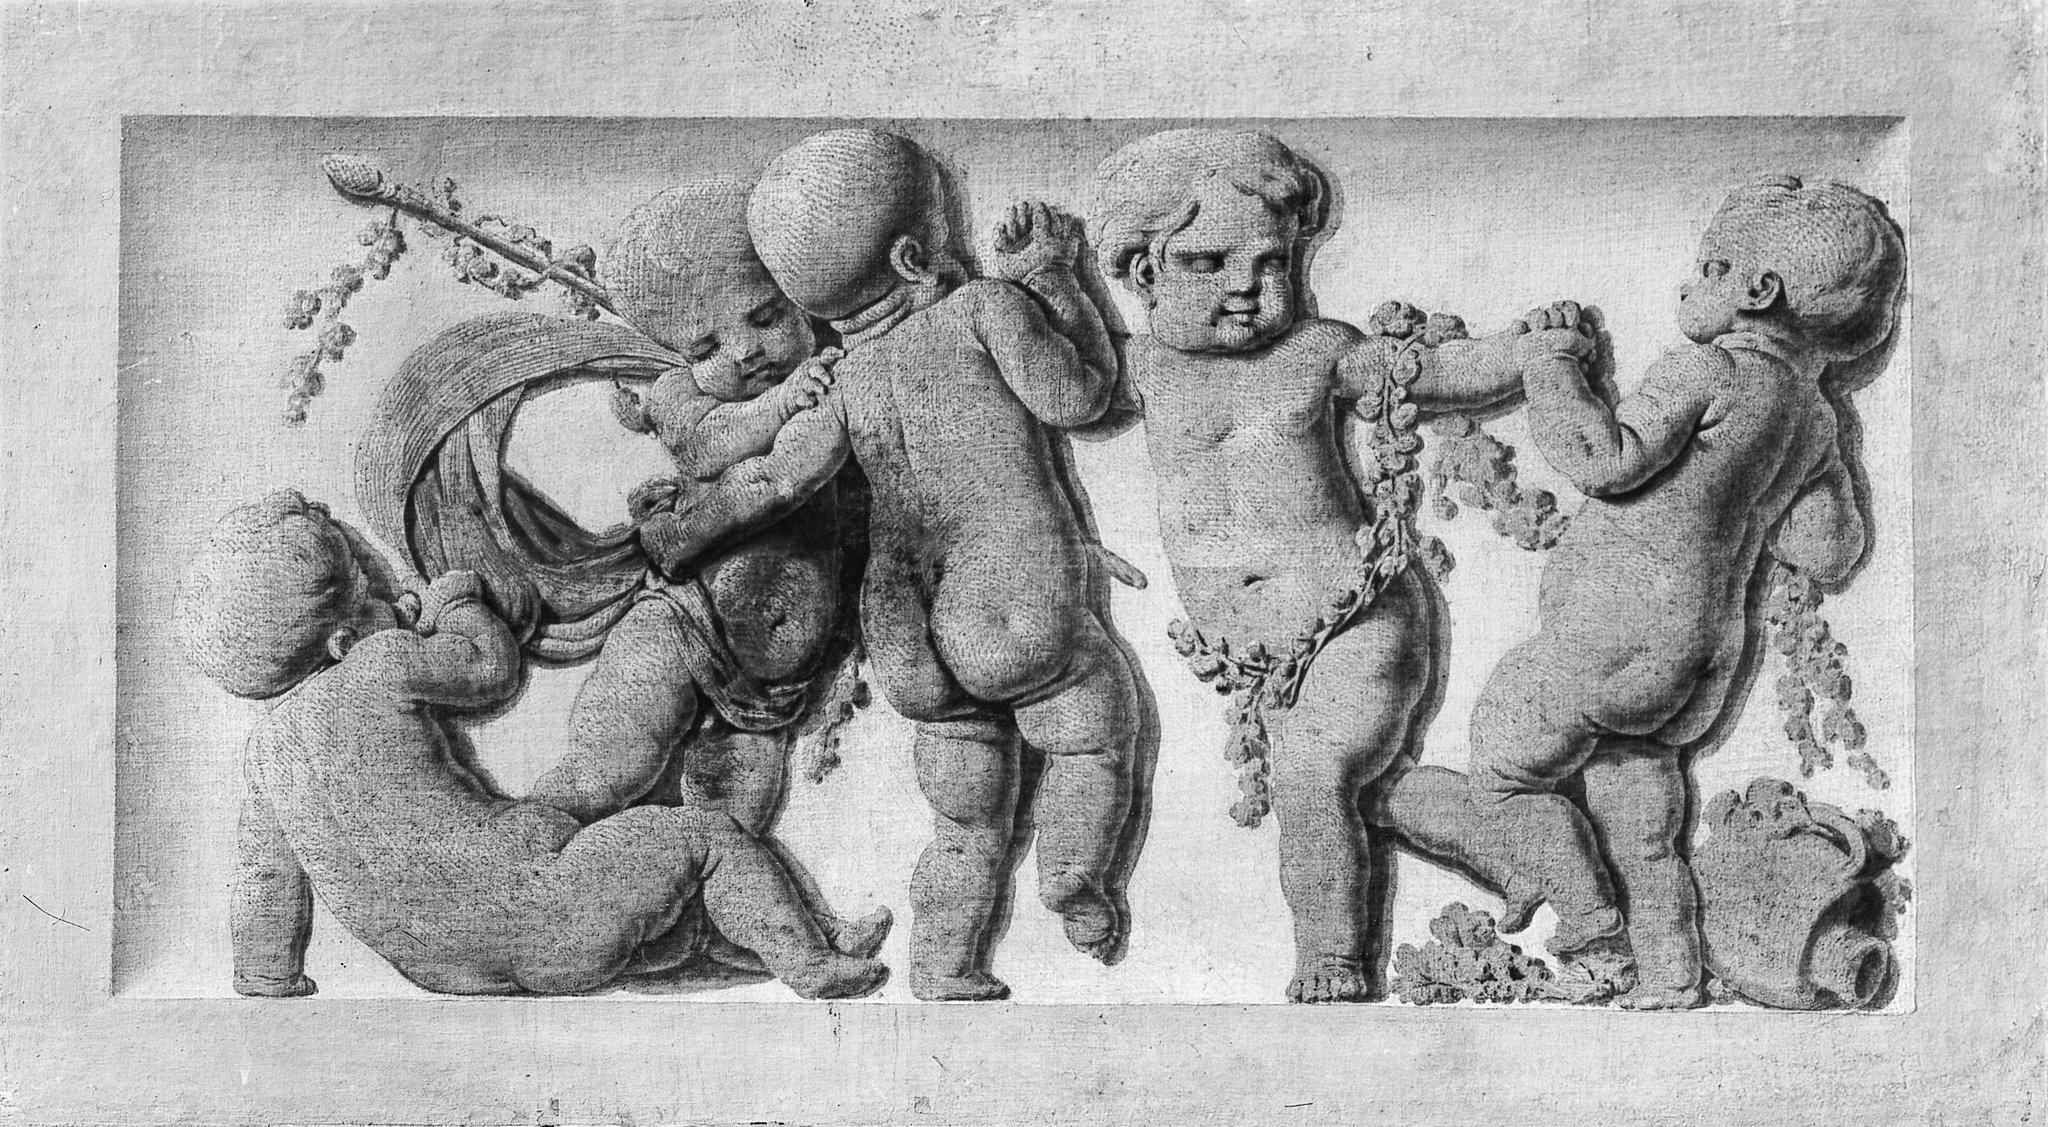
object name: overdoor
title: Dancing children (one of a pair)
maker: donatello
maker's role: artist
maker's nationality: italian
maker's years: 1386-1466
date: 1770-1790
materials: canvas, oil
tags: children,dancing